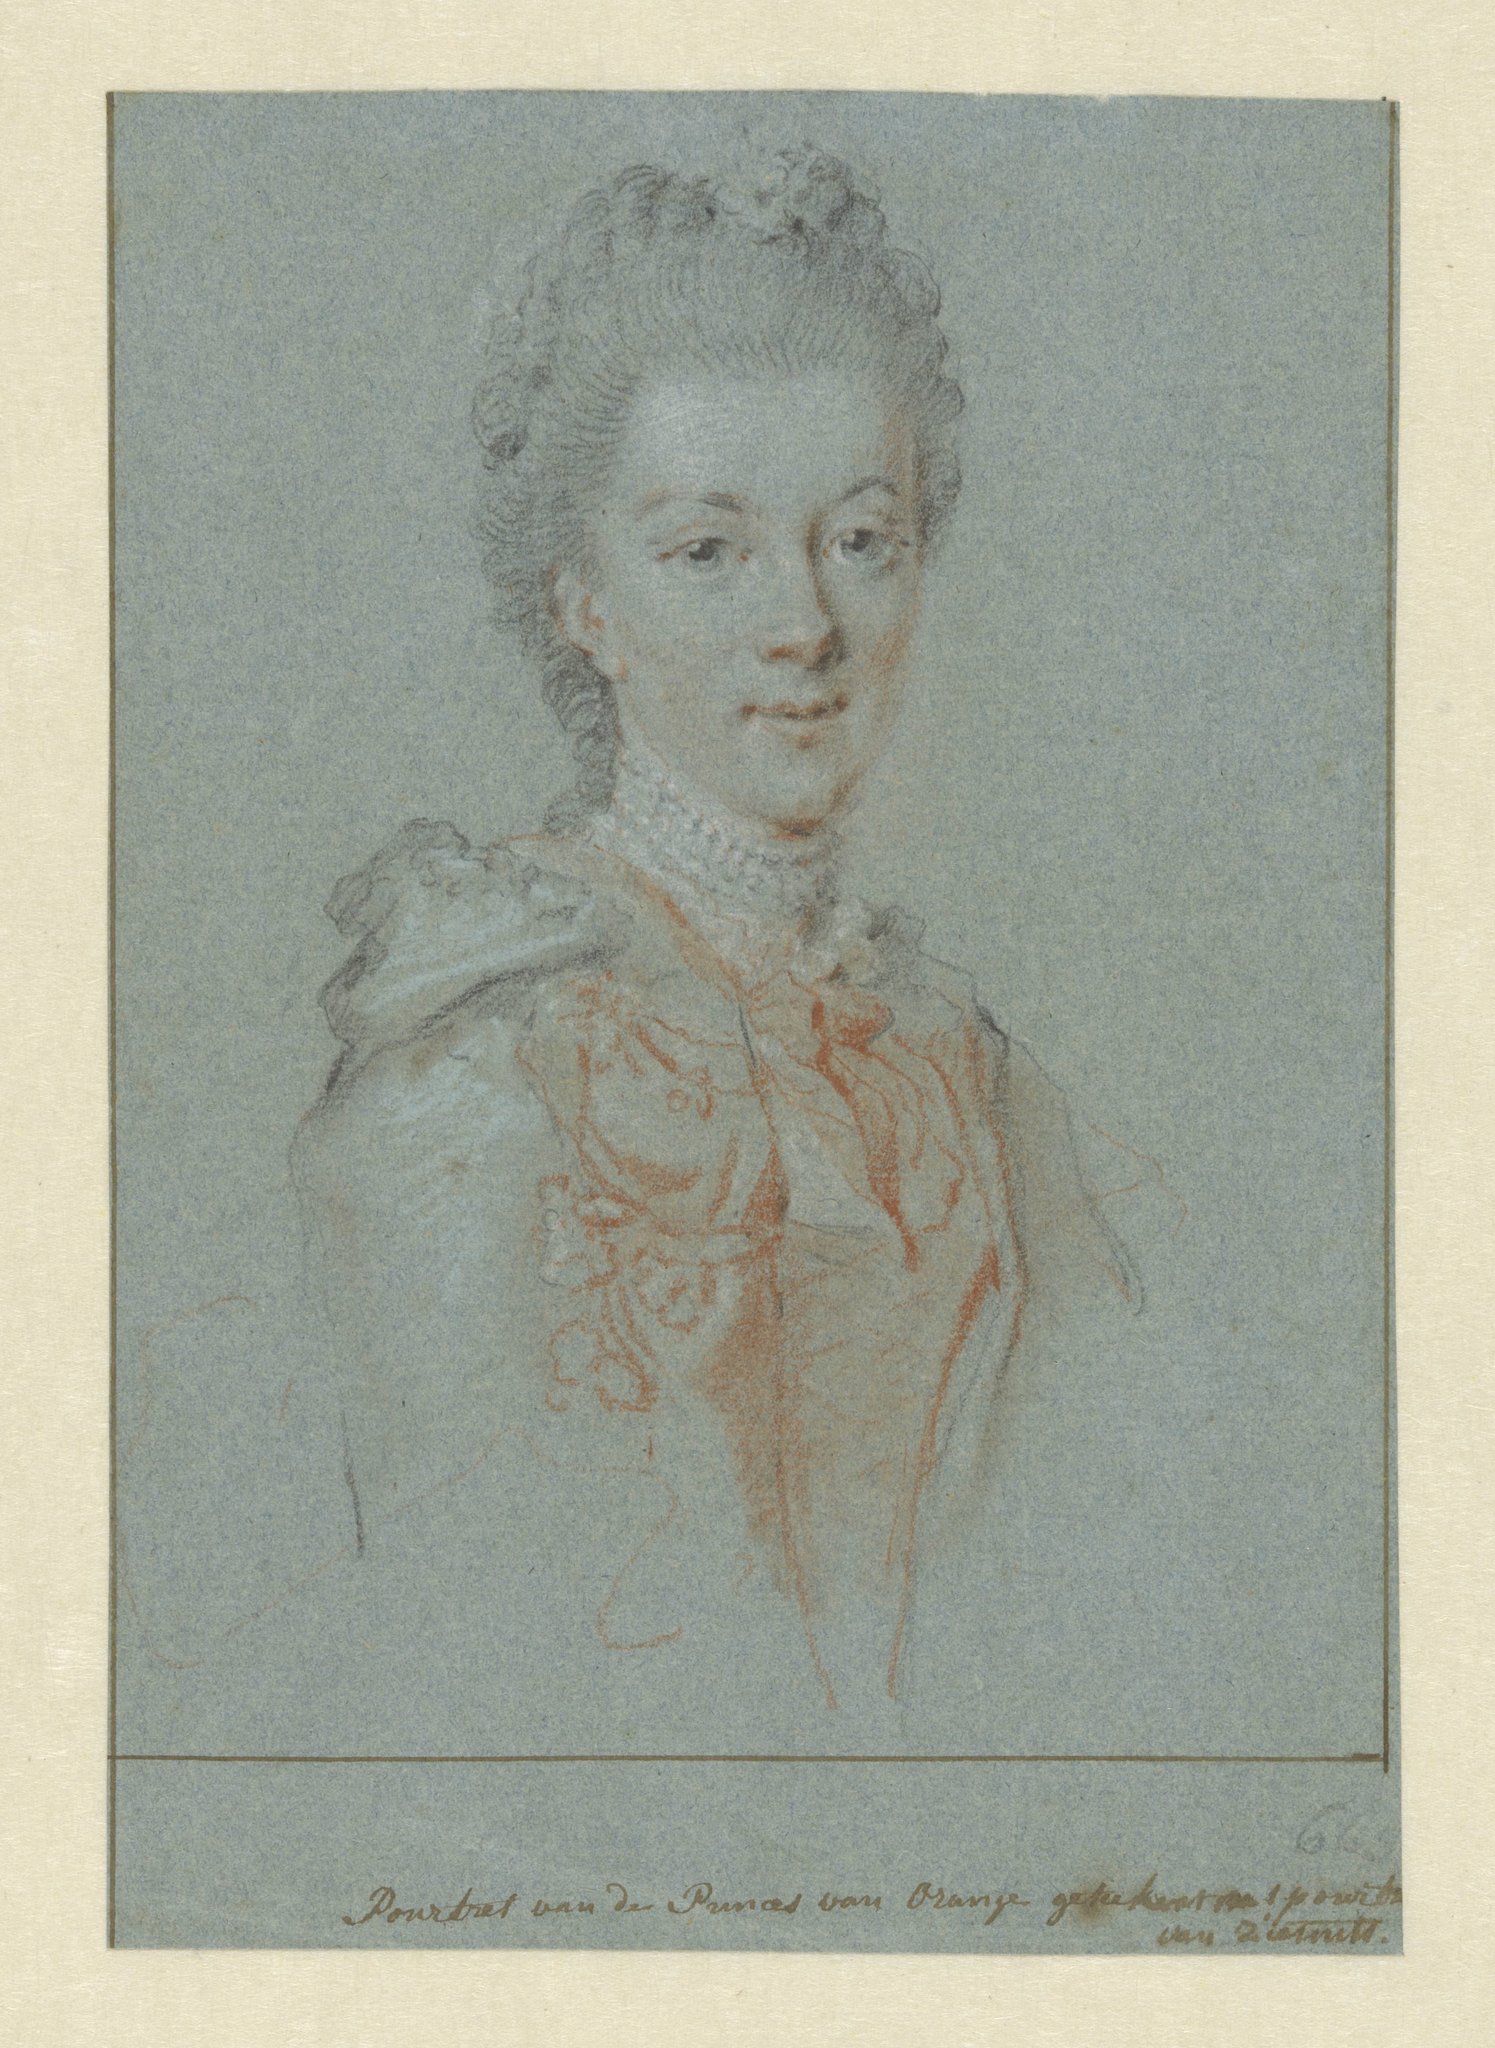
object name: drawing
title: Portret van Wilhelmina Frederica Sophia van Pruisen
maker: aert schouman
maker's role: draughtsman, painter, print maker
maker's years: 1710-1792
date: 1770-1792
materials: chalk, paper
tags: berlin, wilhelmina of prussia (princess of orange), historical persons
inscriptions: inscription: ‘Pourtret van den Princes van Oranje geteekent van 't pourtret van Ziesenits.’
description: Portret van Wilhelmina Frederica Sophia van Pruisen (1751-1820), prinses van Oranje-Nassau.